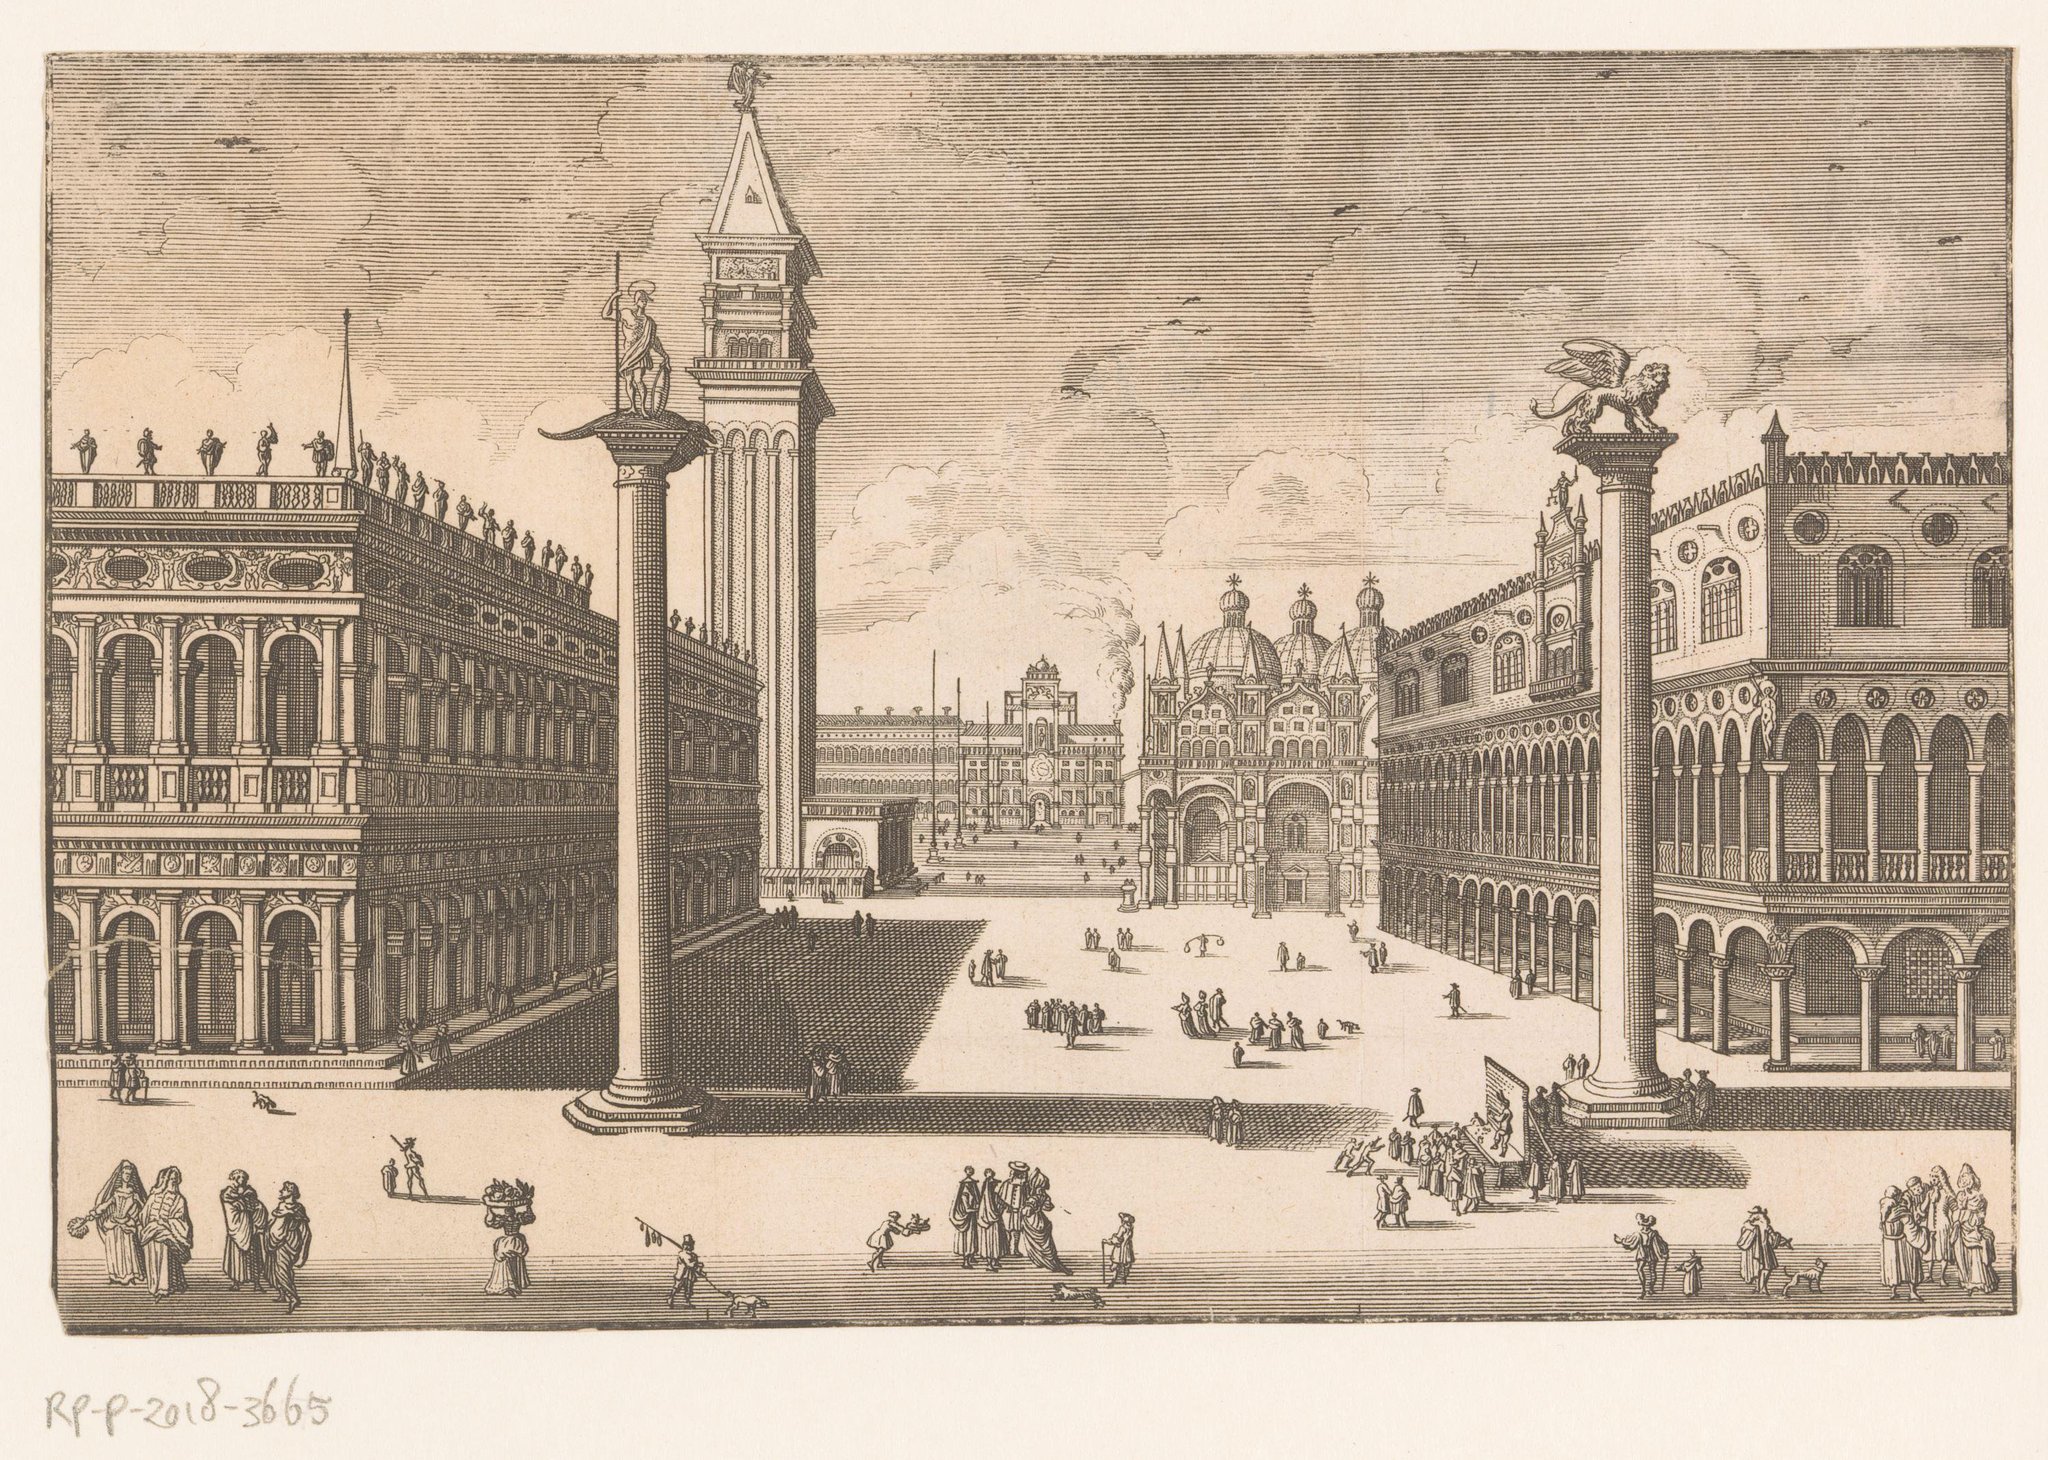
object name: print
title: Gezicht op het San Marcoplein te Venetië vanaf de kant van de Canal Grande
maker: Anonymous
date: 1650-1670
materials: paper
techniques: etching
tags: square, place, circus, etc., city-view, and landscape with man-made constructions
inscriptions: collector's mark: Lugt 2228